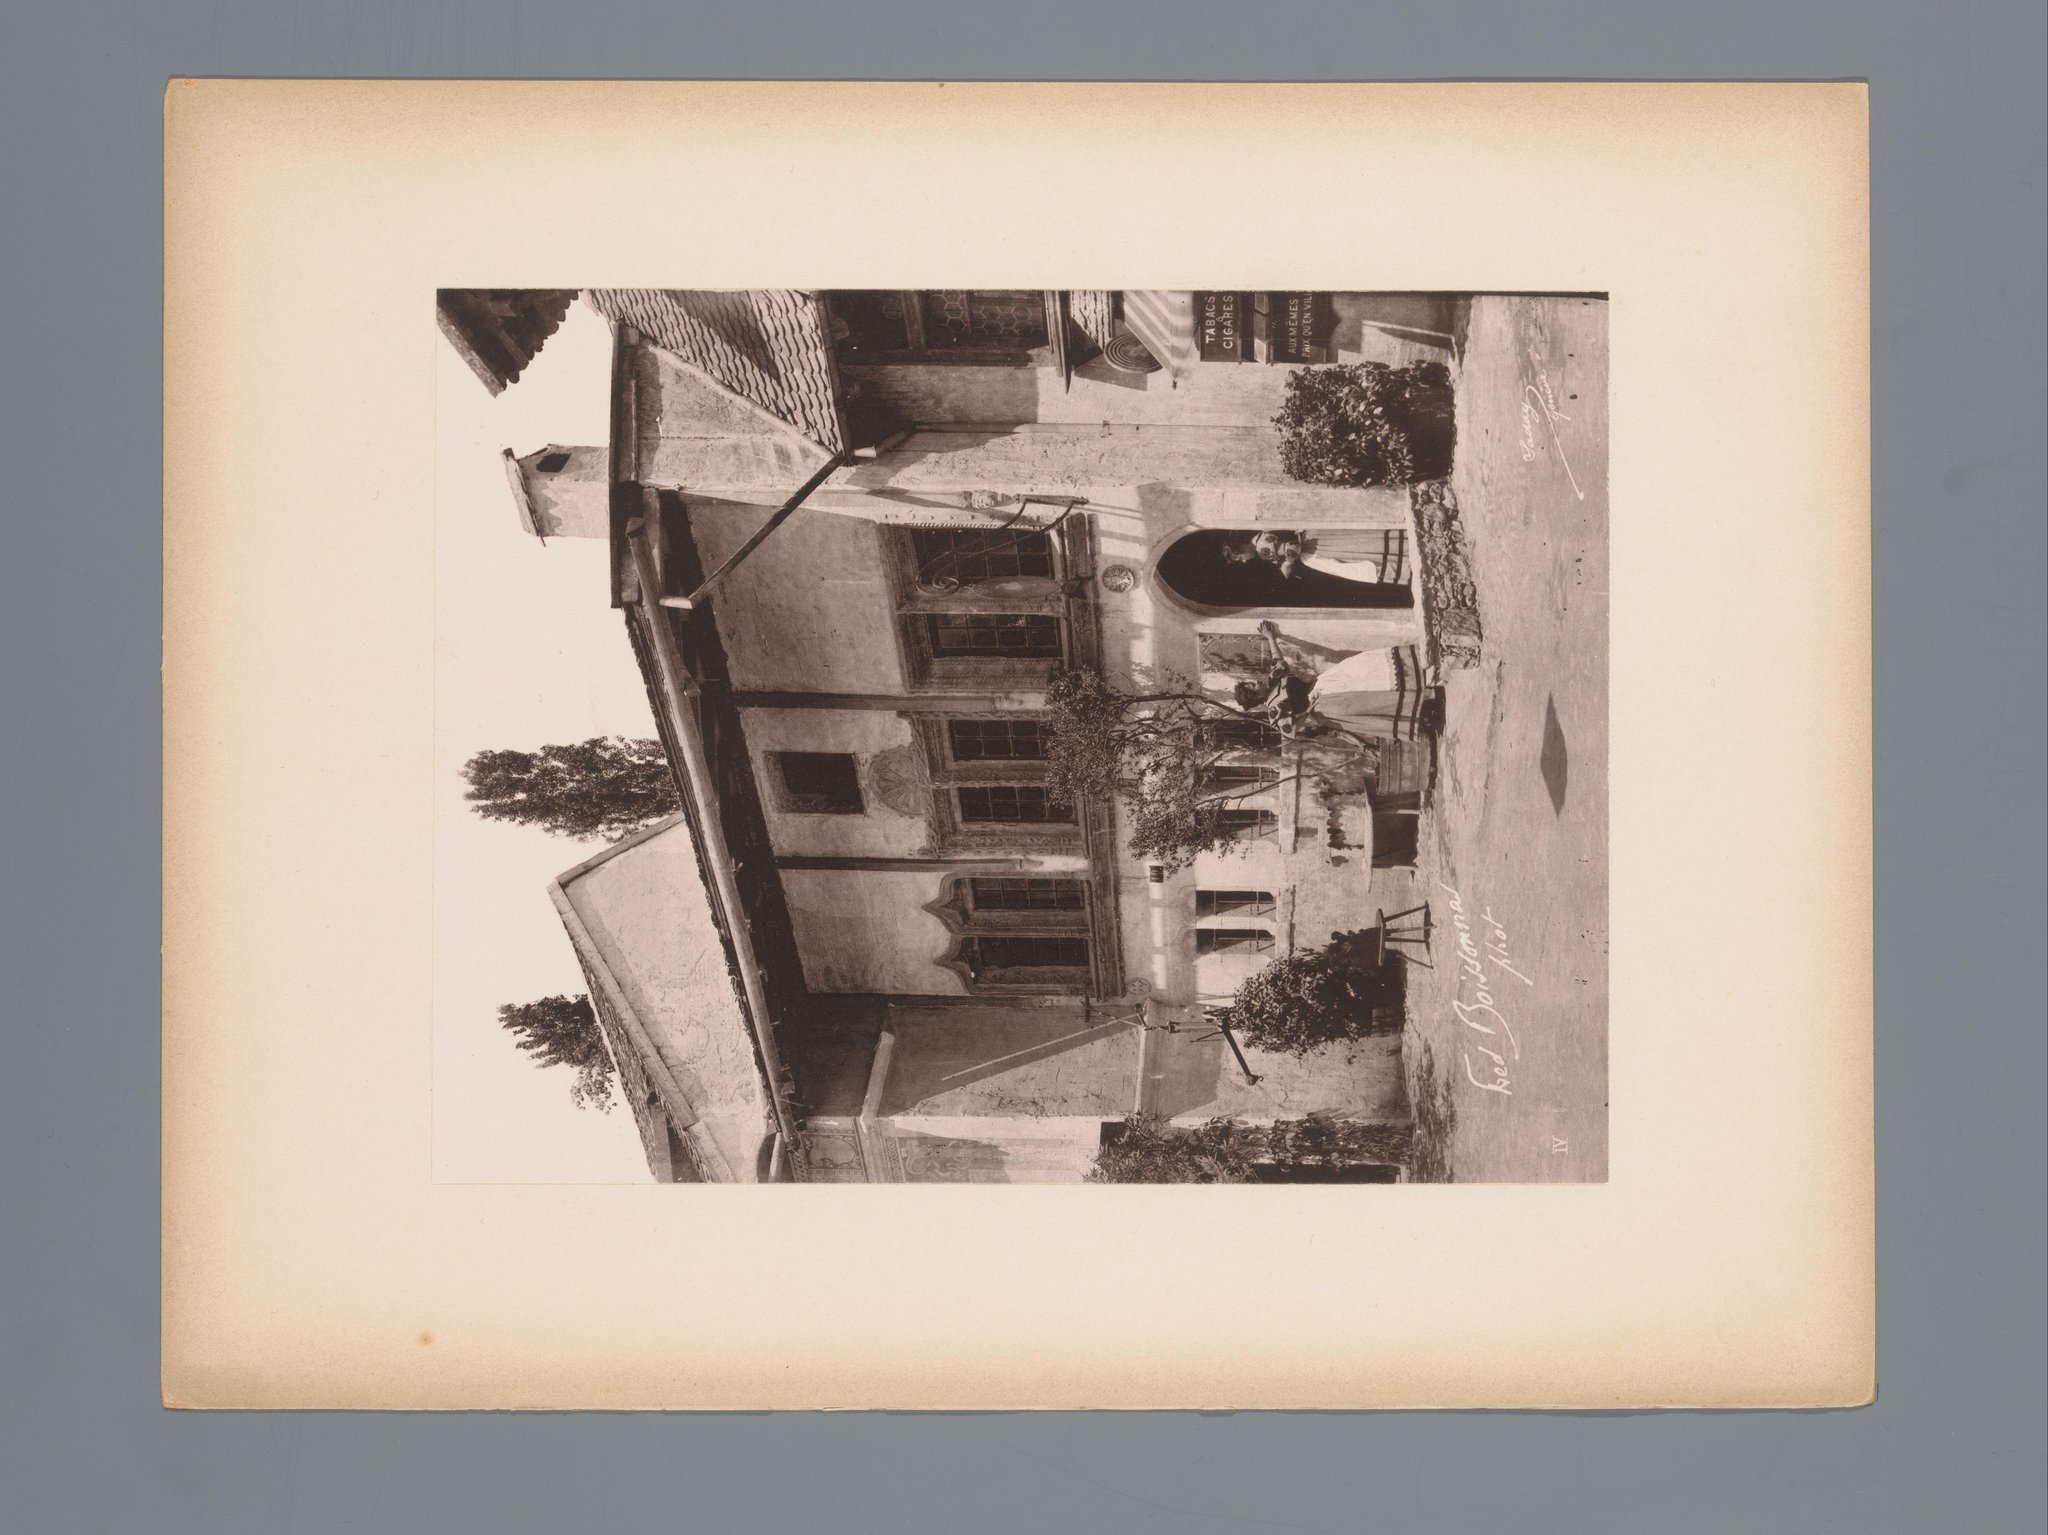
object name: photomechanical print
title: Gezicht op het huis Chalamala te Gruyère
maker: frédéric boissonnas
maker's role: fotograaf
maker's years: 1858-1946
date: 1891-1896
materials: paper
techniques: photograph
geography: gruyères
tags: urban housing